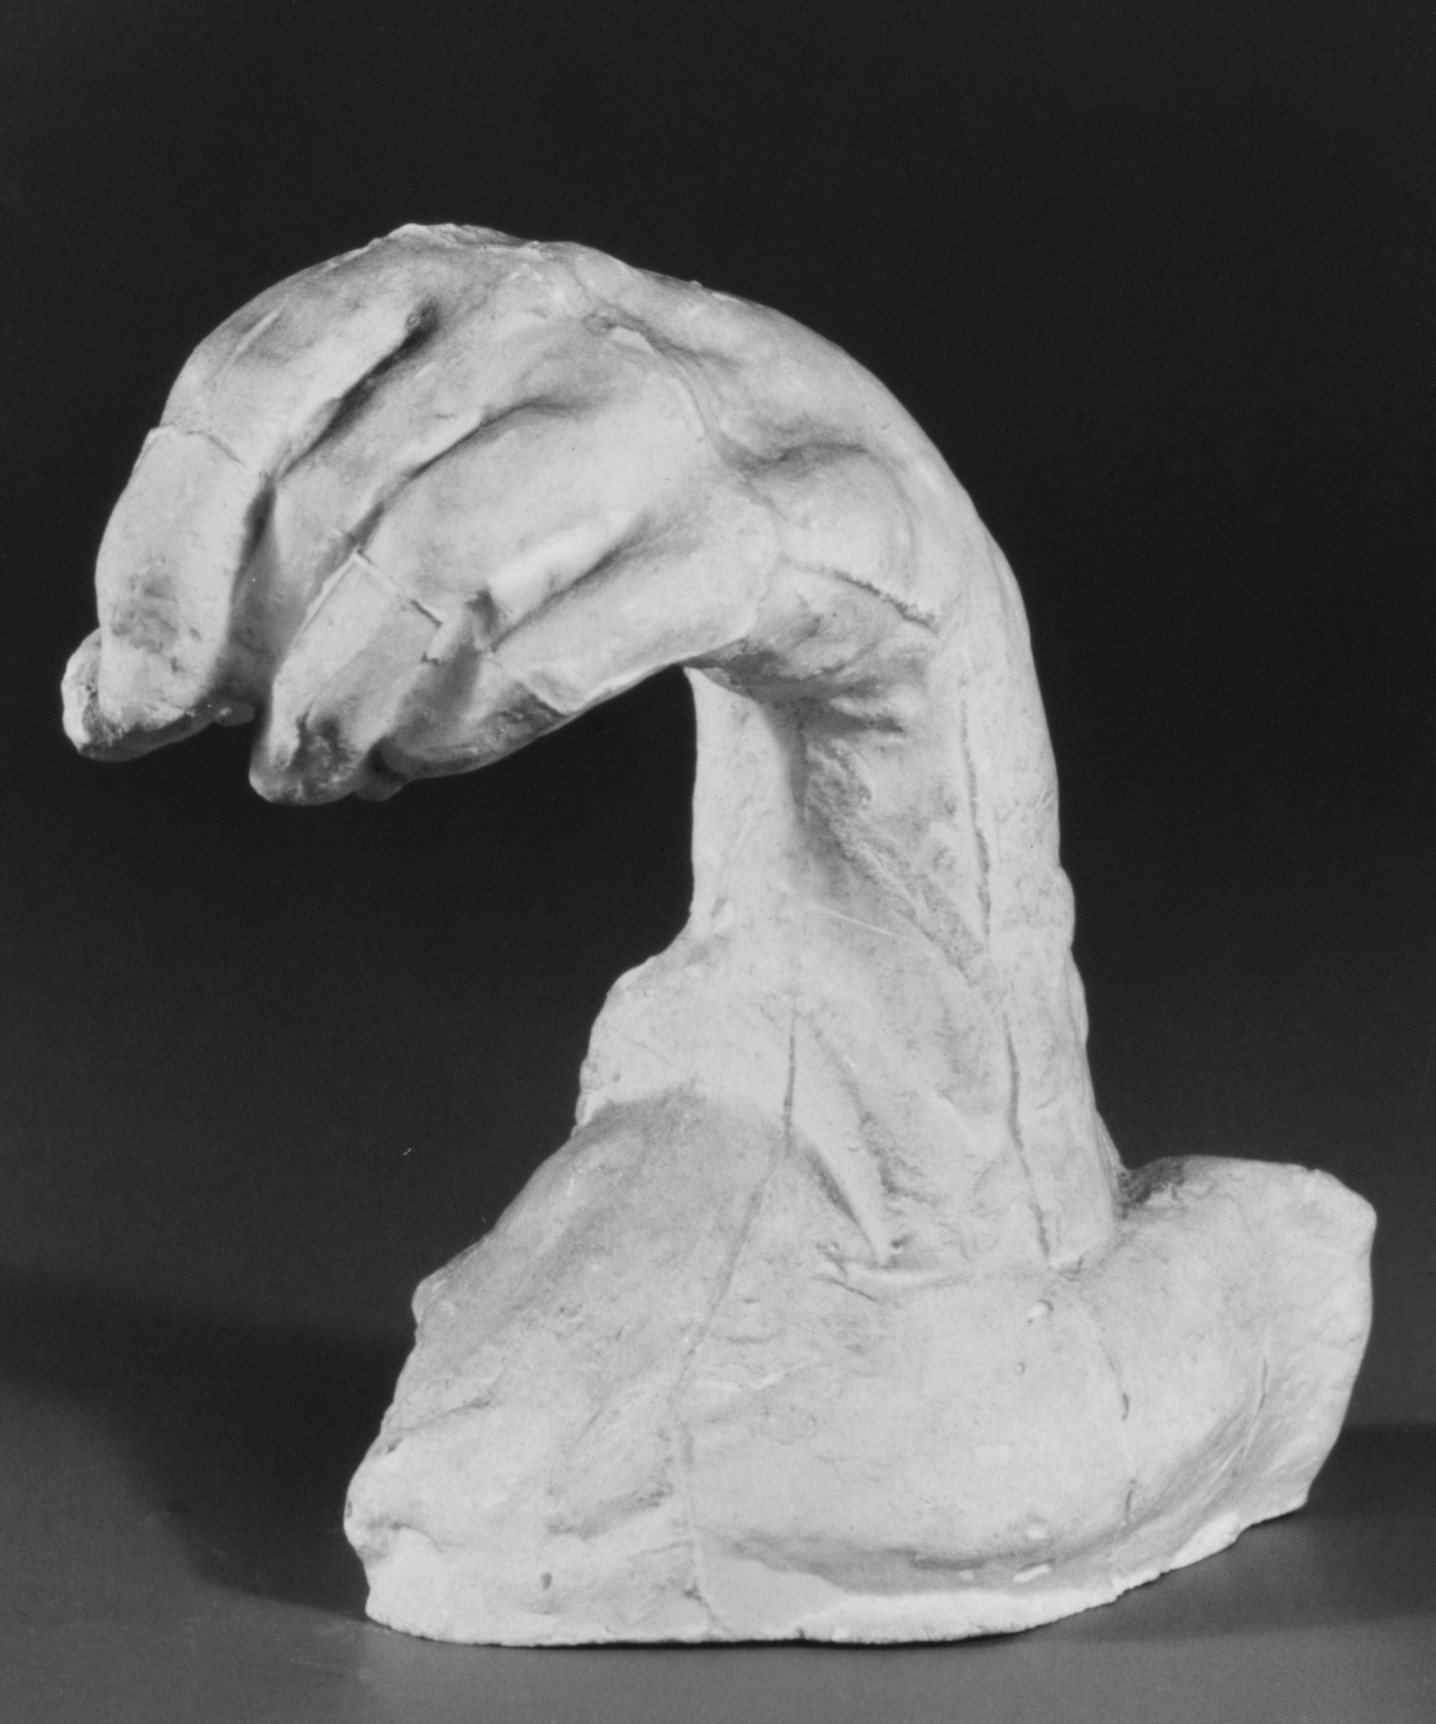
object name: cast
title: Hand with base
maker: auguste rodin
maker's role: artist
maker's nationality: french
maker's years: 1840-1917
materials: plaster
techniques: casting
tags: hands